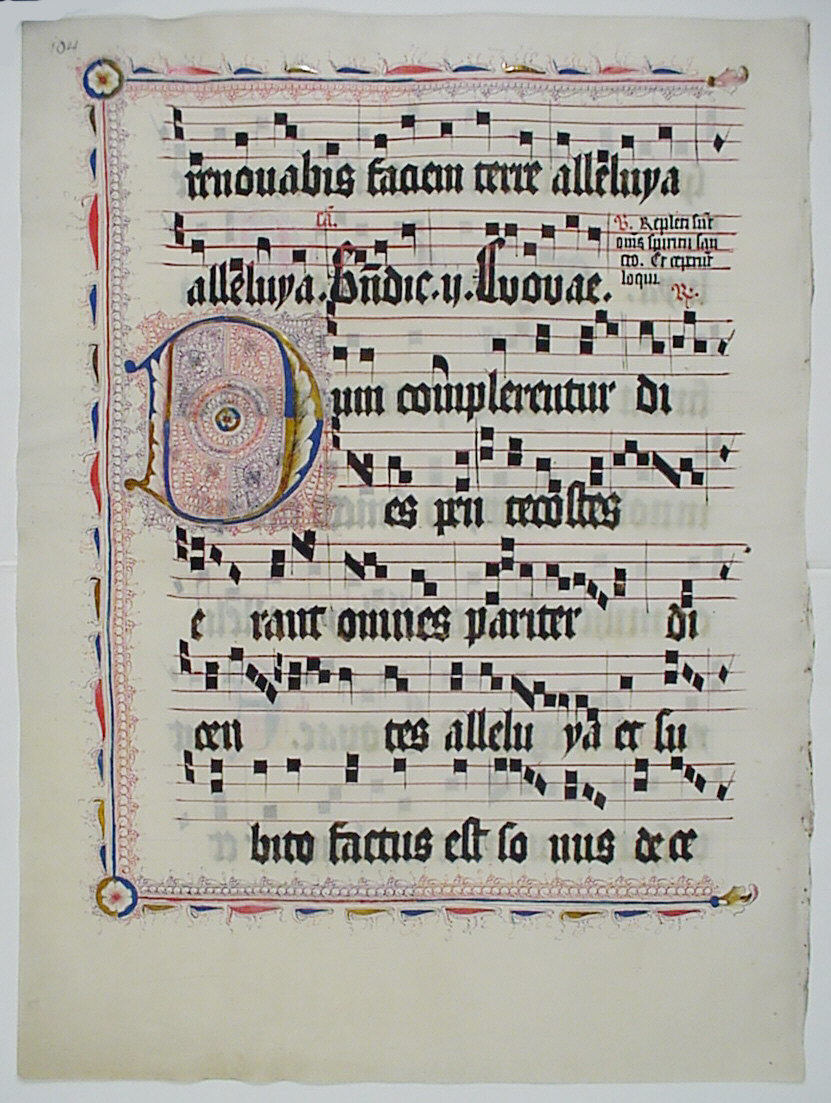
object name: antiphonary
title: Manuscript Leaf with Initial D, from an Antiphonary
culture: german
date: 1426-1450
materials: ink, metal leaf, parchment, paint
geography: germany